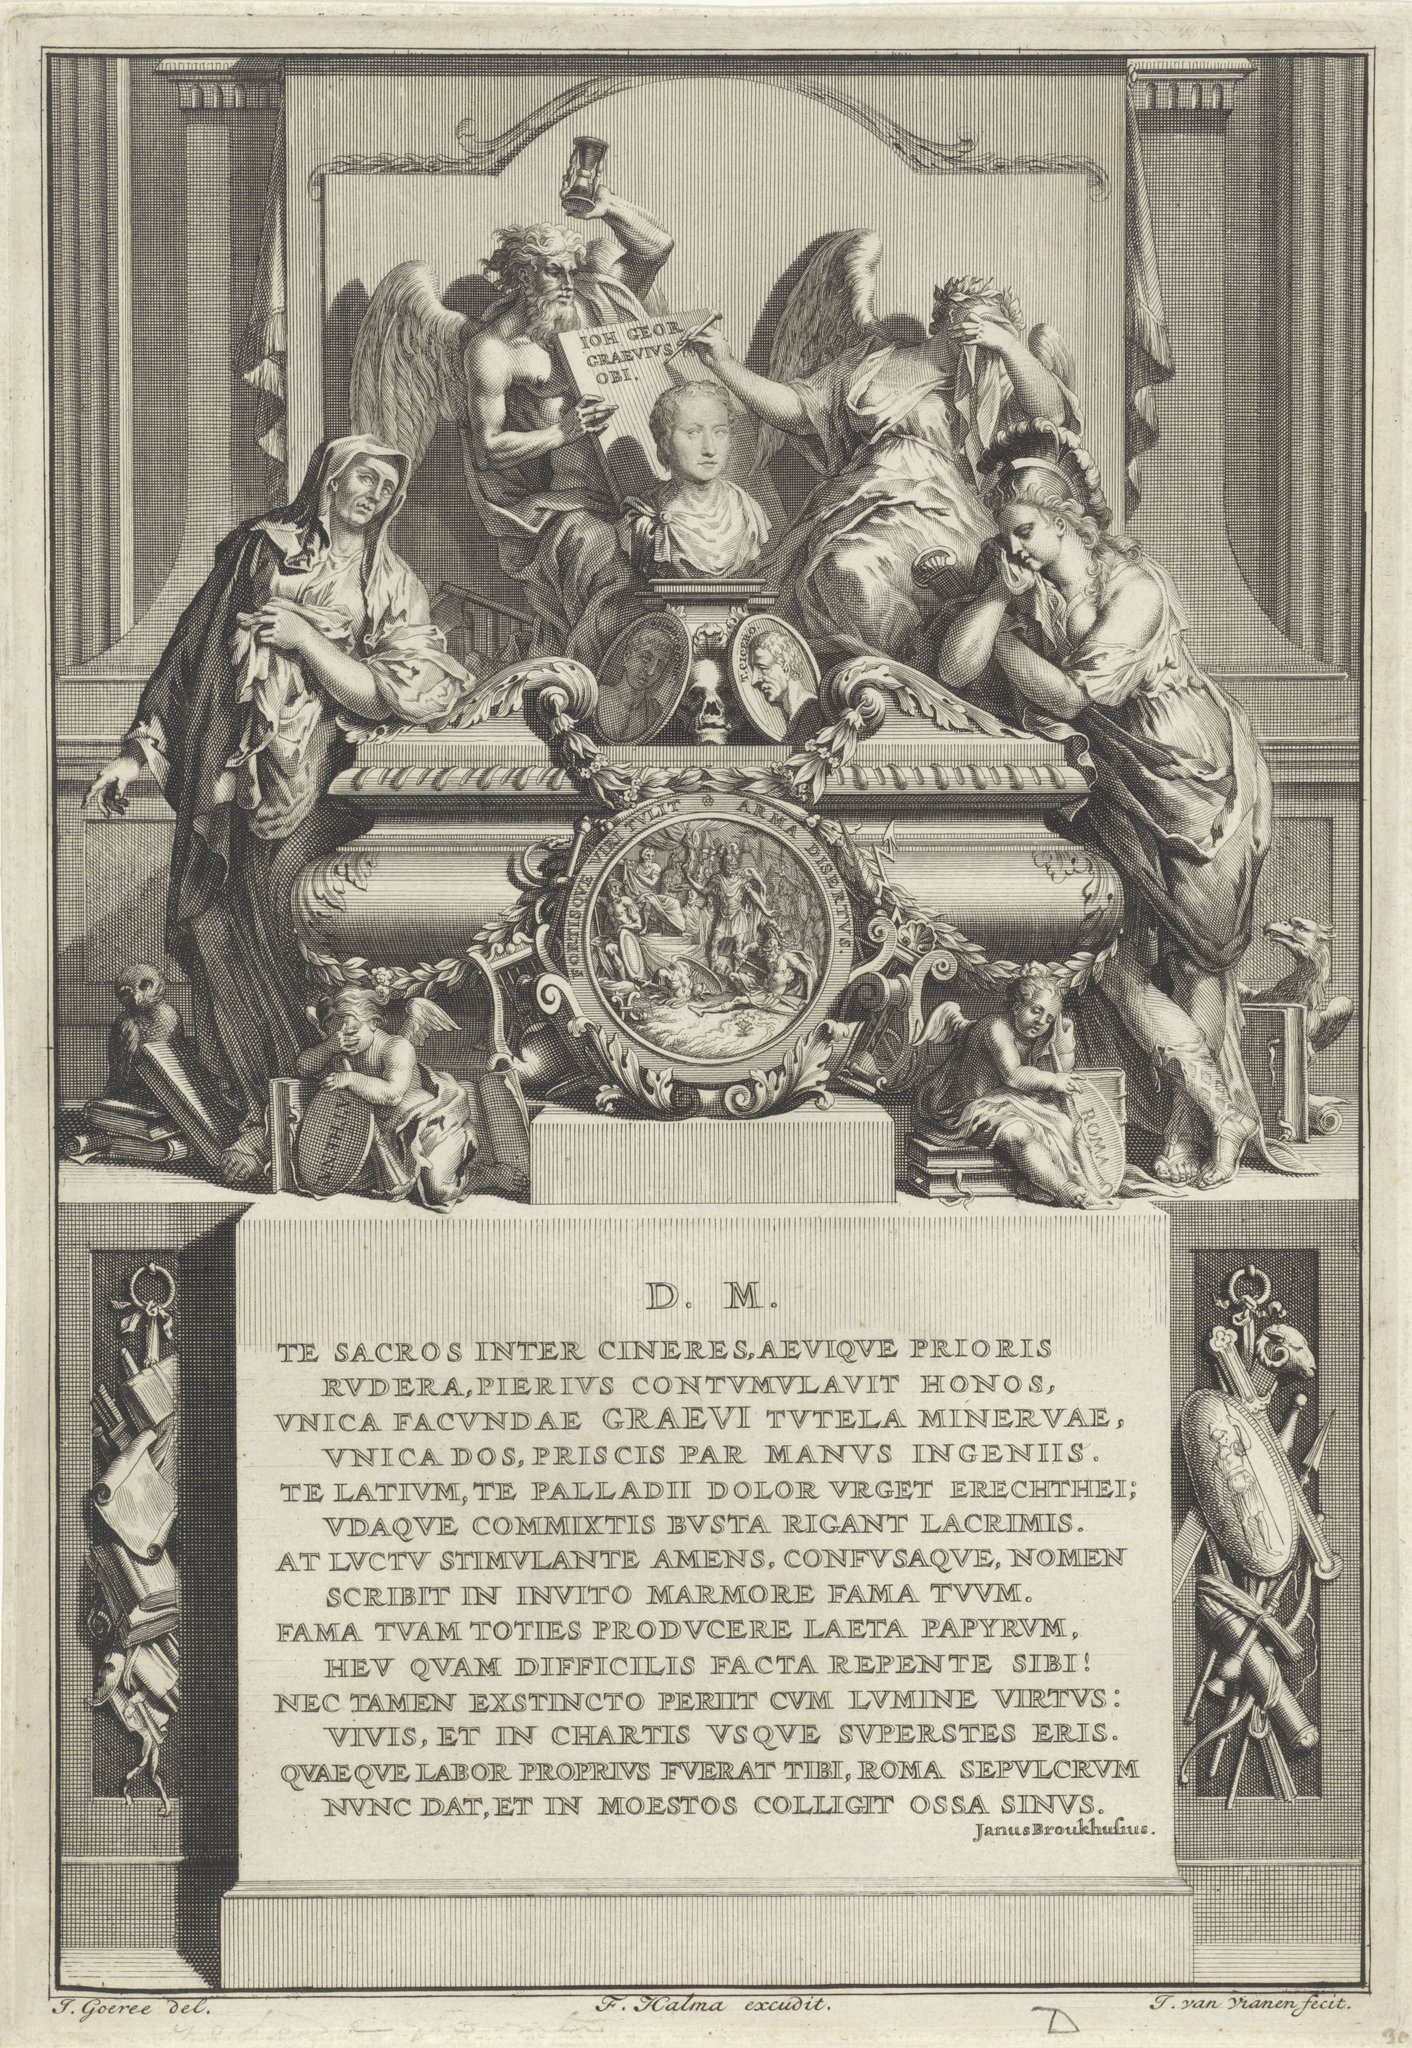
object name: print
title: Tombe van Johann Georg Graevius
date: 1703-1705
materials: paper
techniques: engraving, etching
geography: northern netherlands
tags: grave, tomb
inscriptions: collector's mark: Lugt 2228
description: Tombe met het borstbeeld van de schrijver en geleerde Johann Georg Graevius, geflankeerd door verschillende allegorische figuren.